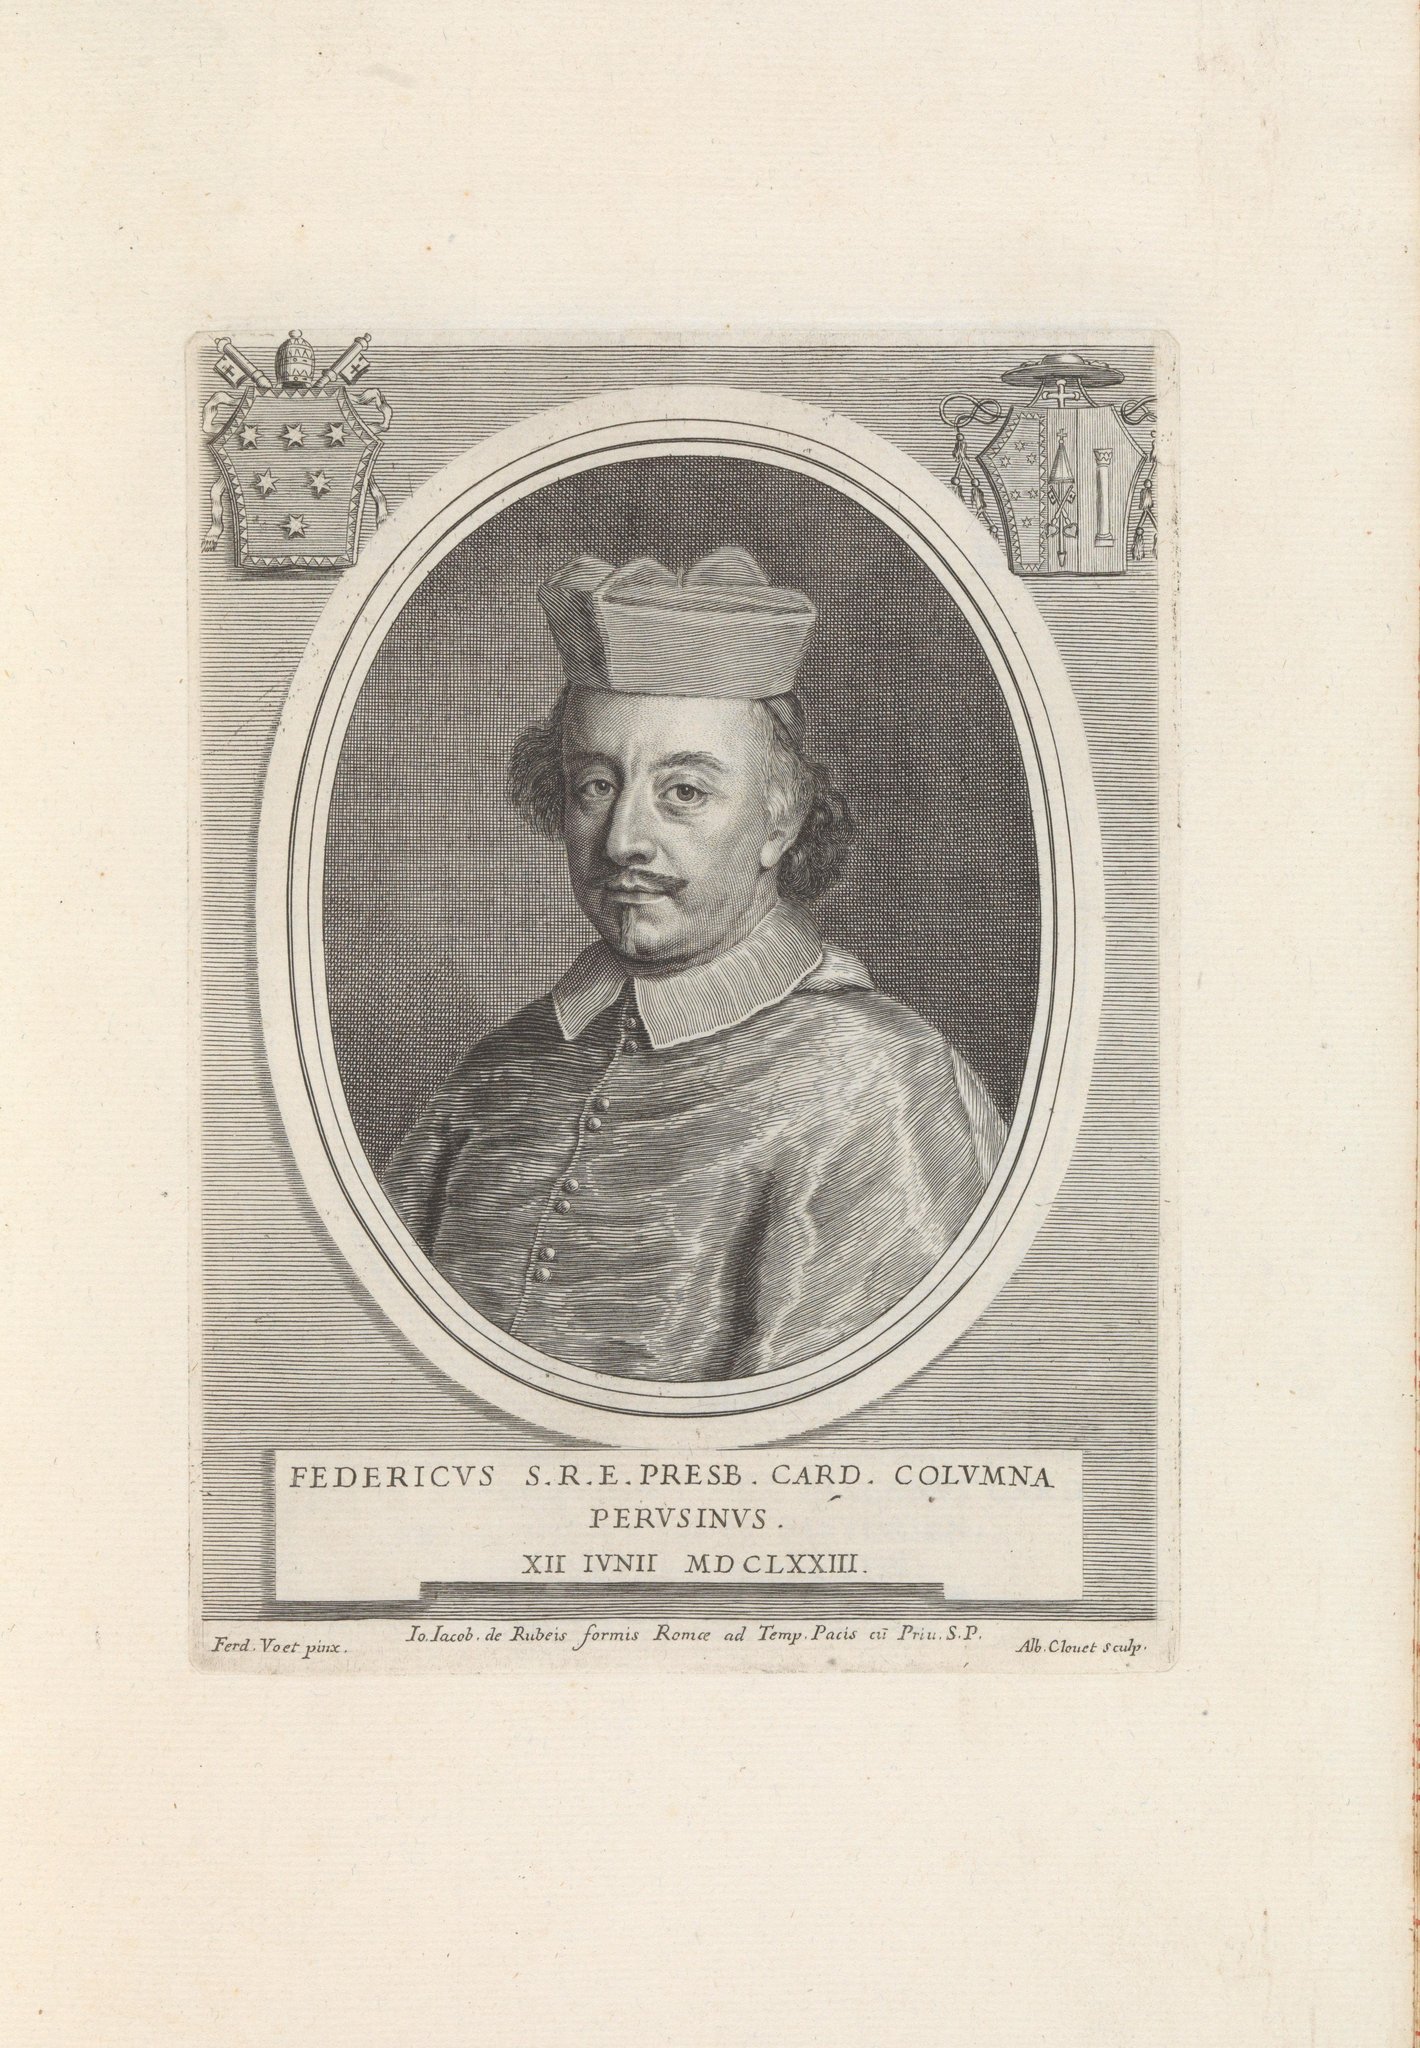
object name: album leaf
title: Effigies Nomina et Cognomina S.D.N. Alexandri Papae VII et RR. DD. SRE. Cardd (...).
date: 1673-1679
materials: paper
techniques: engraving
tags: rome, cardinal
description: Portret van kardinaal Federico Baldeschi Colonna. Linksboven het wapen van paus Clemens X en rechtsboven het wapen van de kardinaal. Onderaan een onderschrift in het Latijn. De prent maakt deel uit van een album.